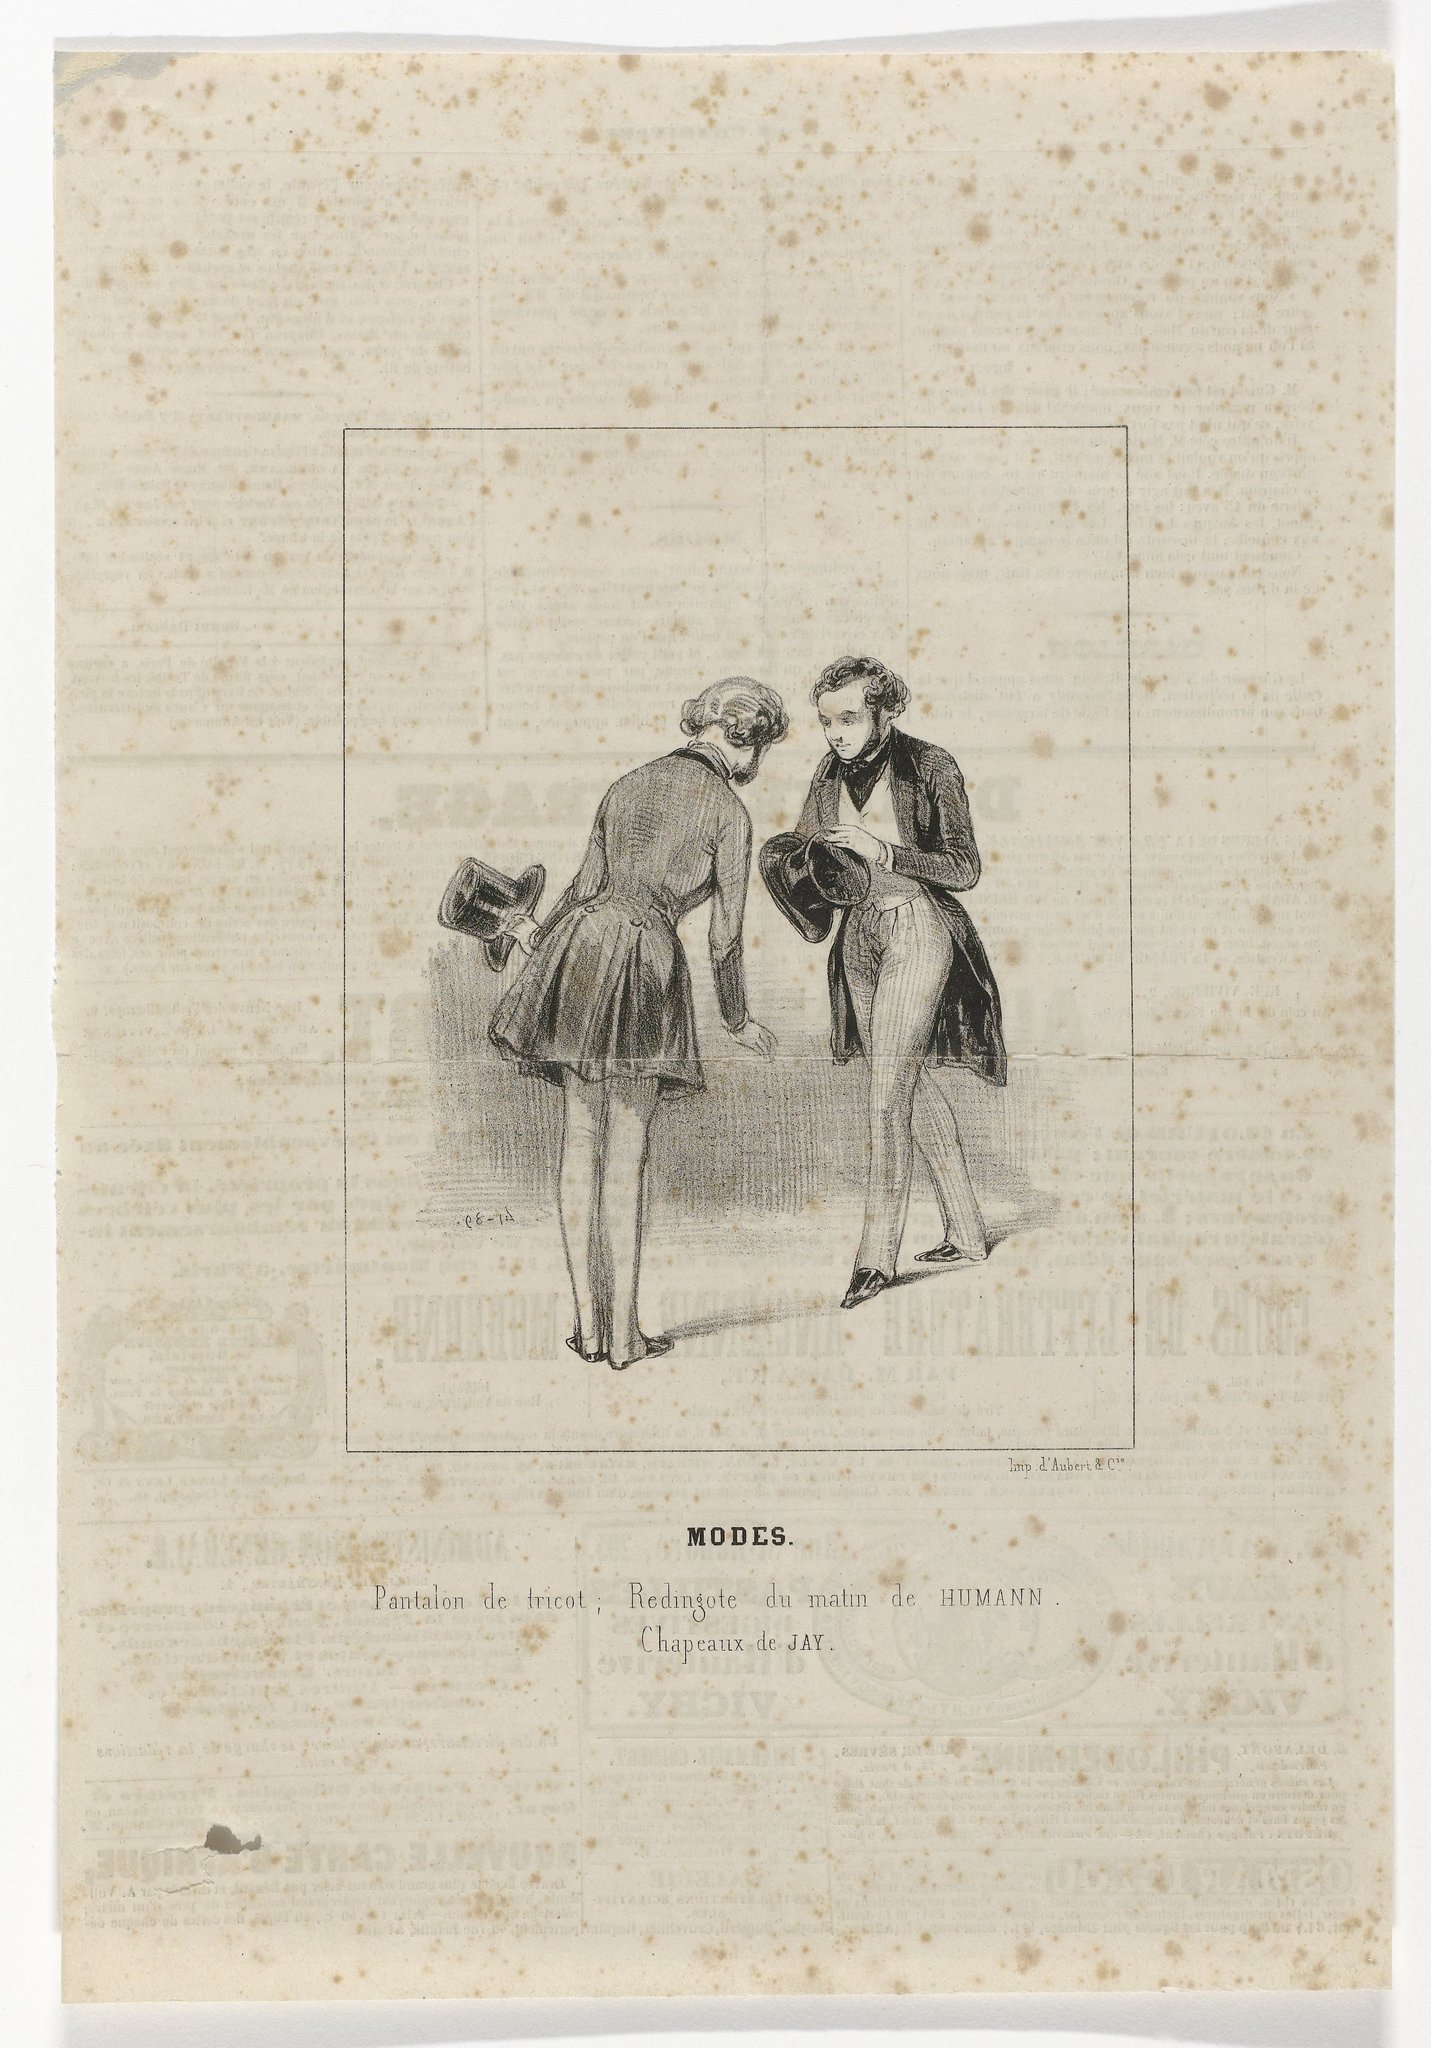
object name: fashion print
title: Le Charivari, sept. 1841 : Modes. Pantalon de tricot (...)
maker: Anonymous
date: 1841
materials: paper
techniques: lithograph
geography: paris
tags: trousers, breeches, etc. (pantalon) (+ men's clothes), baring the head, lifting one's hat, coat (+ men's clothes), fashion plates, head bent forward; bowing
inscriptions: title: ‘MODES.’, caption: ‘Pantalon de tricot; Redingote du matin de HUMANN. Chapeaux de JAY.’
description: Twee mannen die naar elkaar buigen. Lange broek van tricot. Redingote voor de ochtend van Humann. Hoeden van Jay. Verso: bespreking van het kostuum onder het kopje 'MODES'.